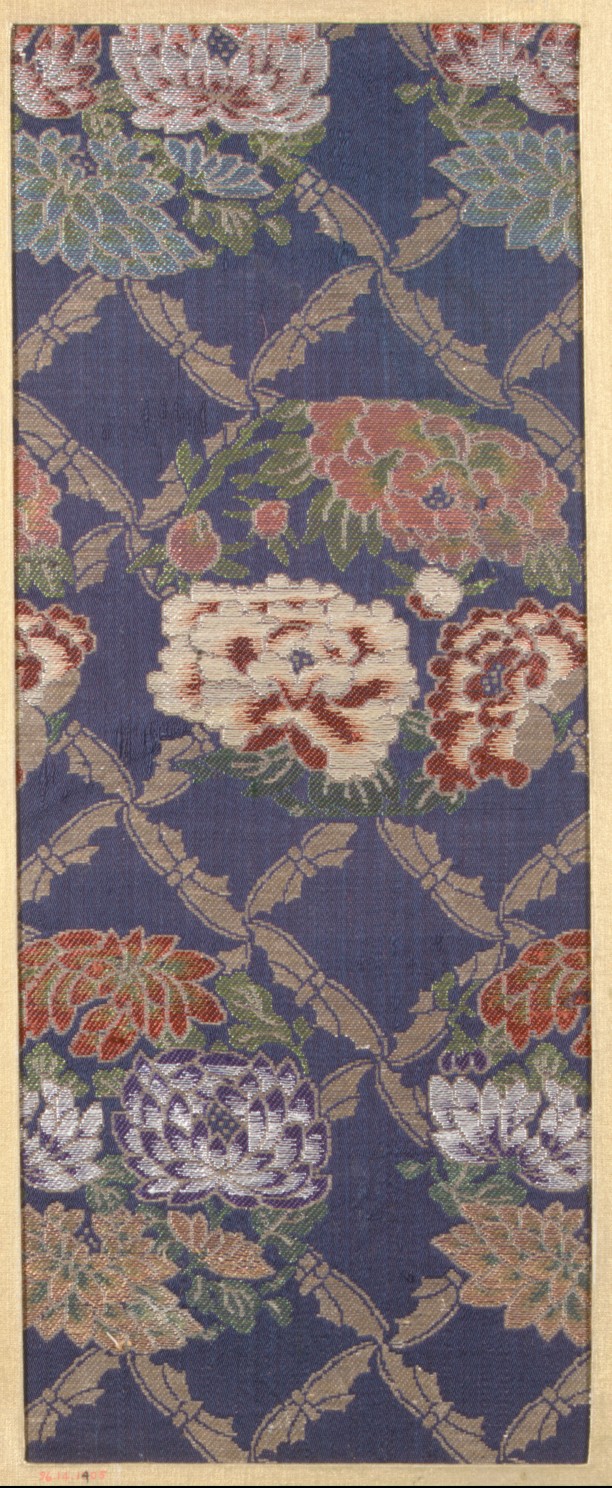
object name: piece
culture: japanese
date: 1701-1900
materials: silk